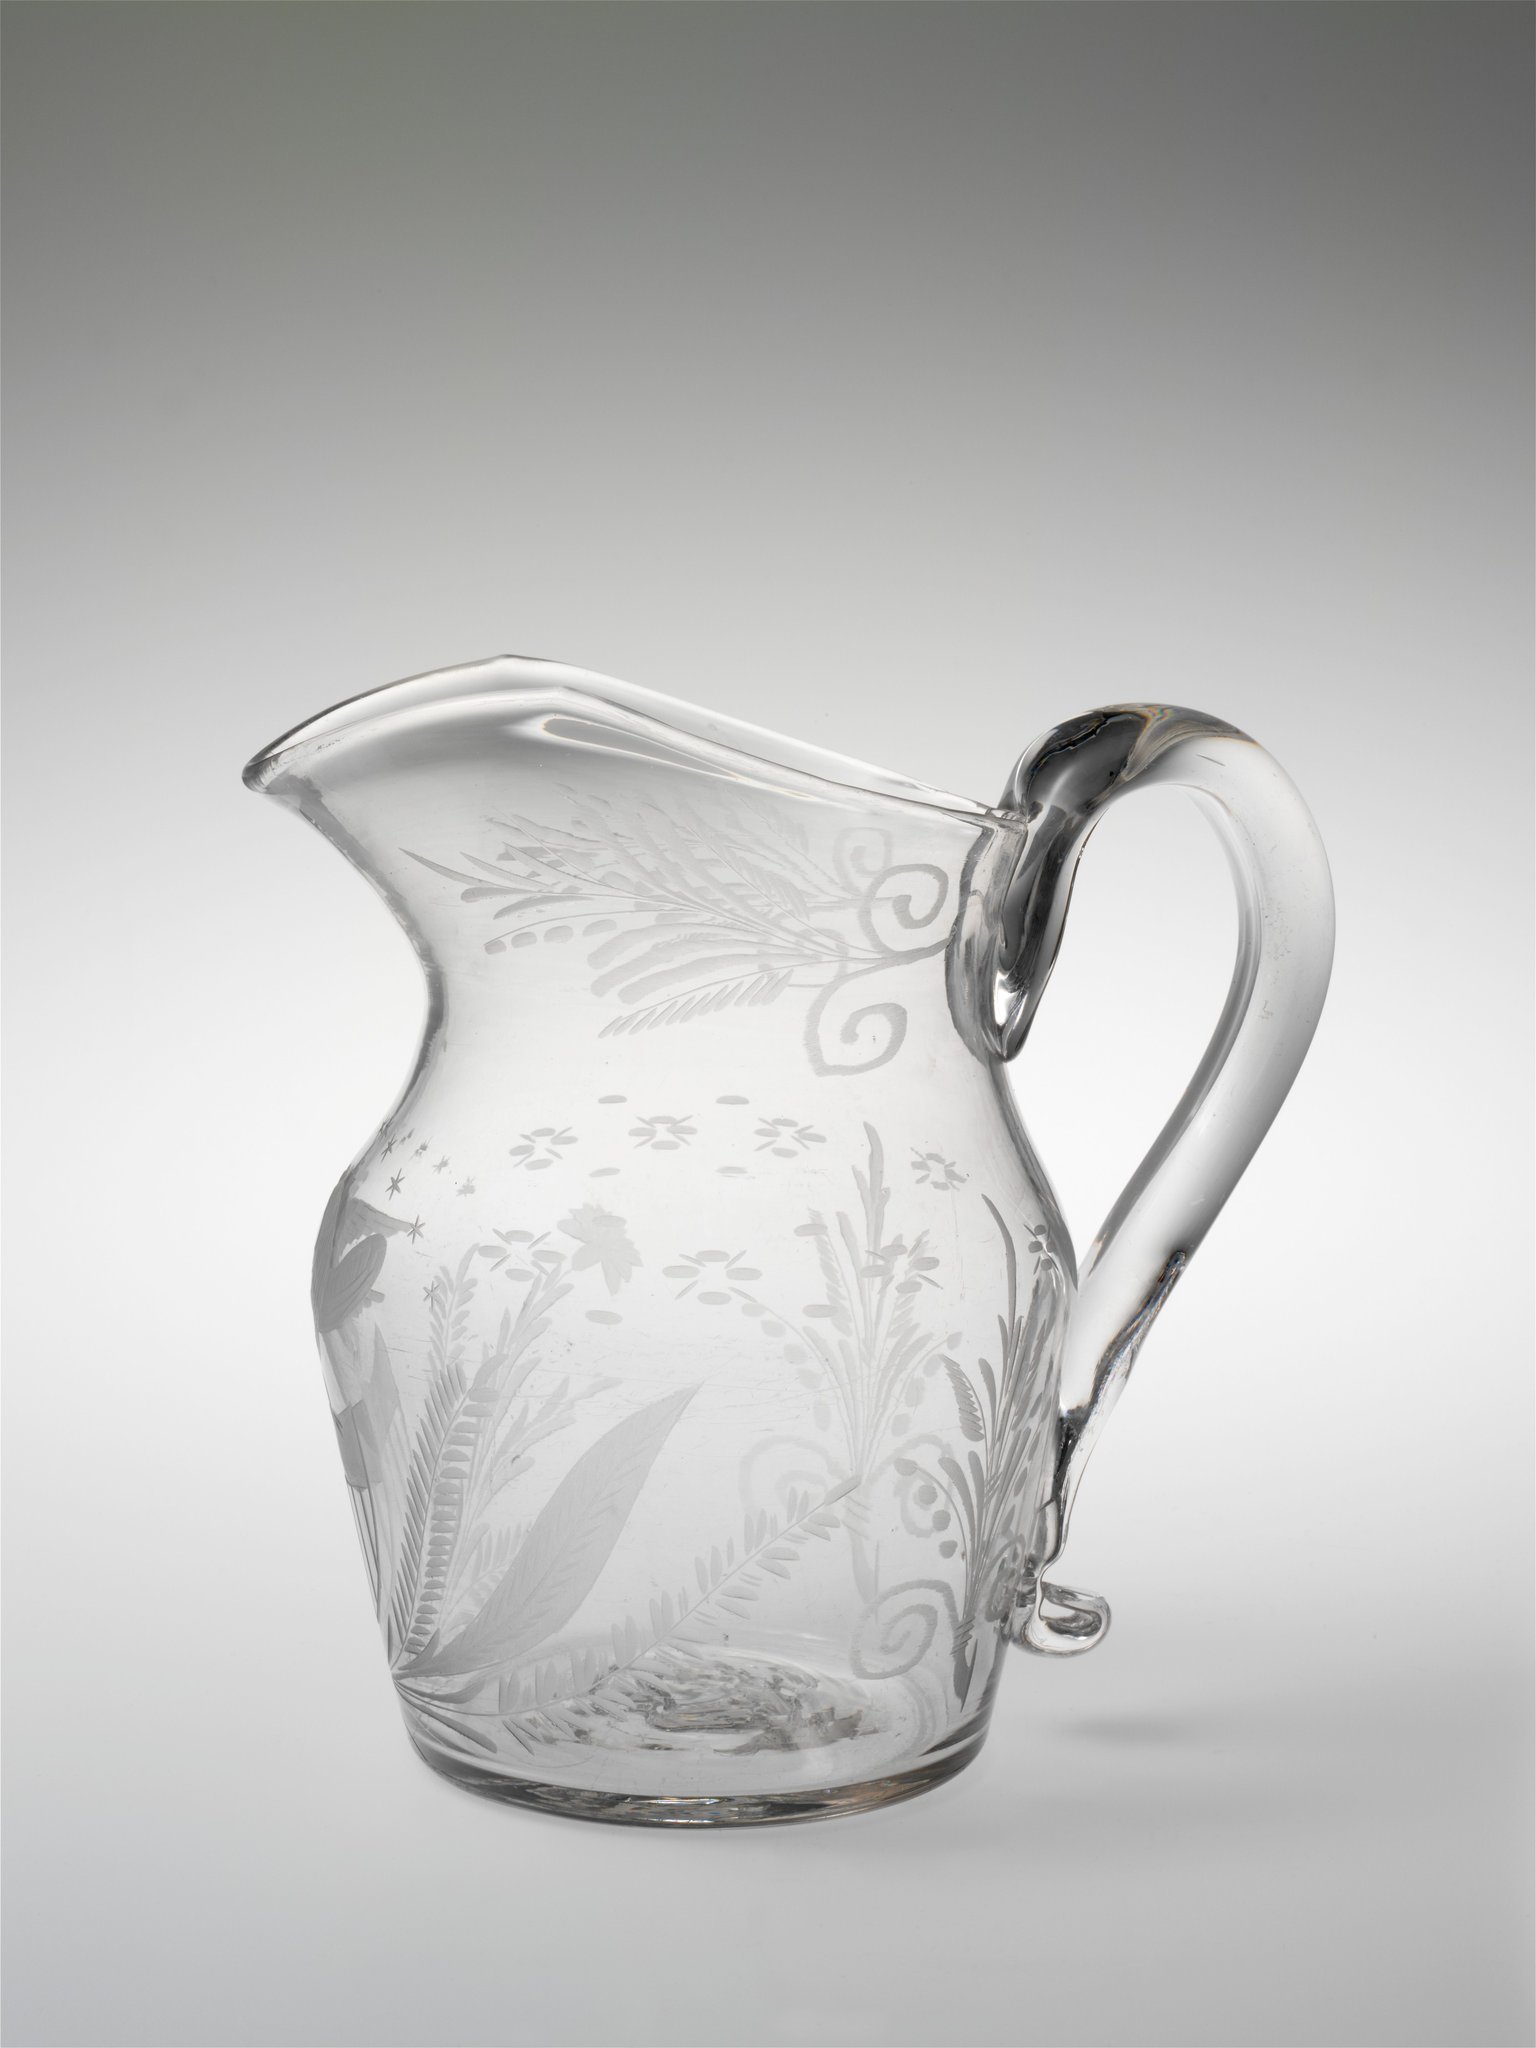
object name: pitcher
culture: american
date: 1820-1840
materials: glass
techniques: glassblowing, engraving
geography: united states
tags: eagles